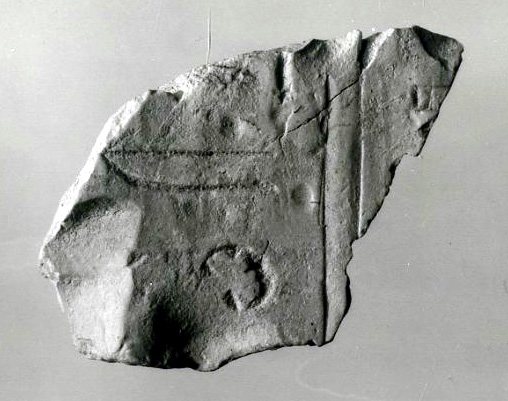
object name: relief fragment, tomb of meketre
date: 1981-1975 BCE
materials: limestone, paint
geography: egypt